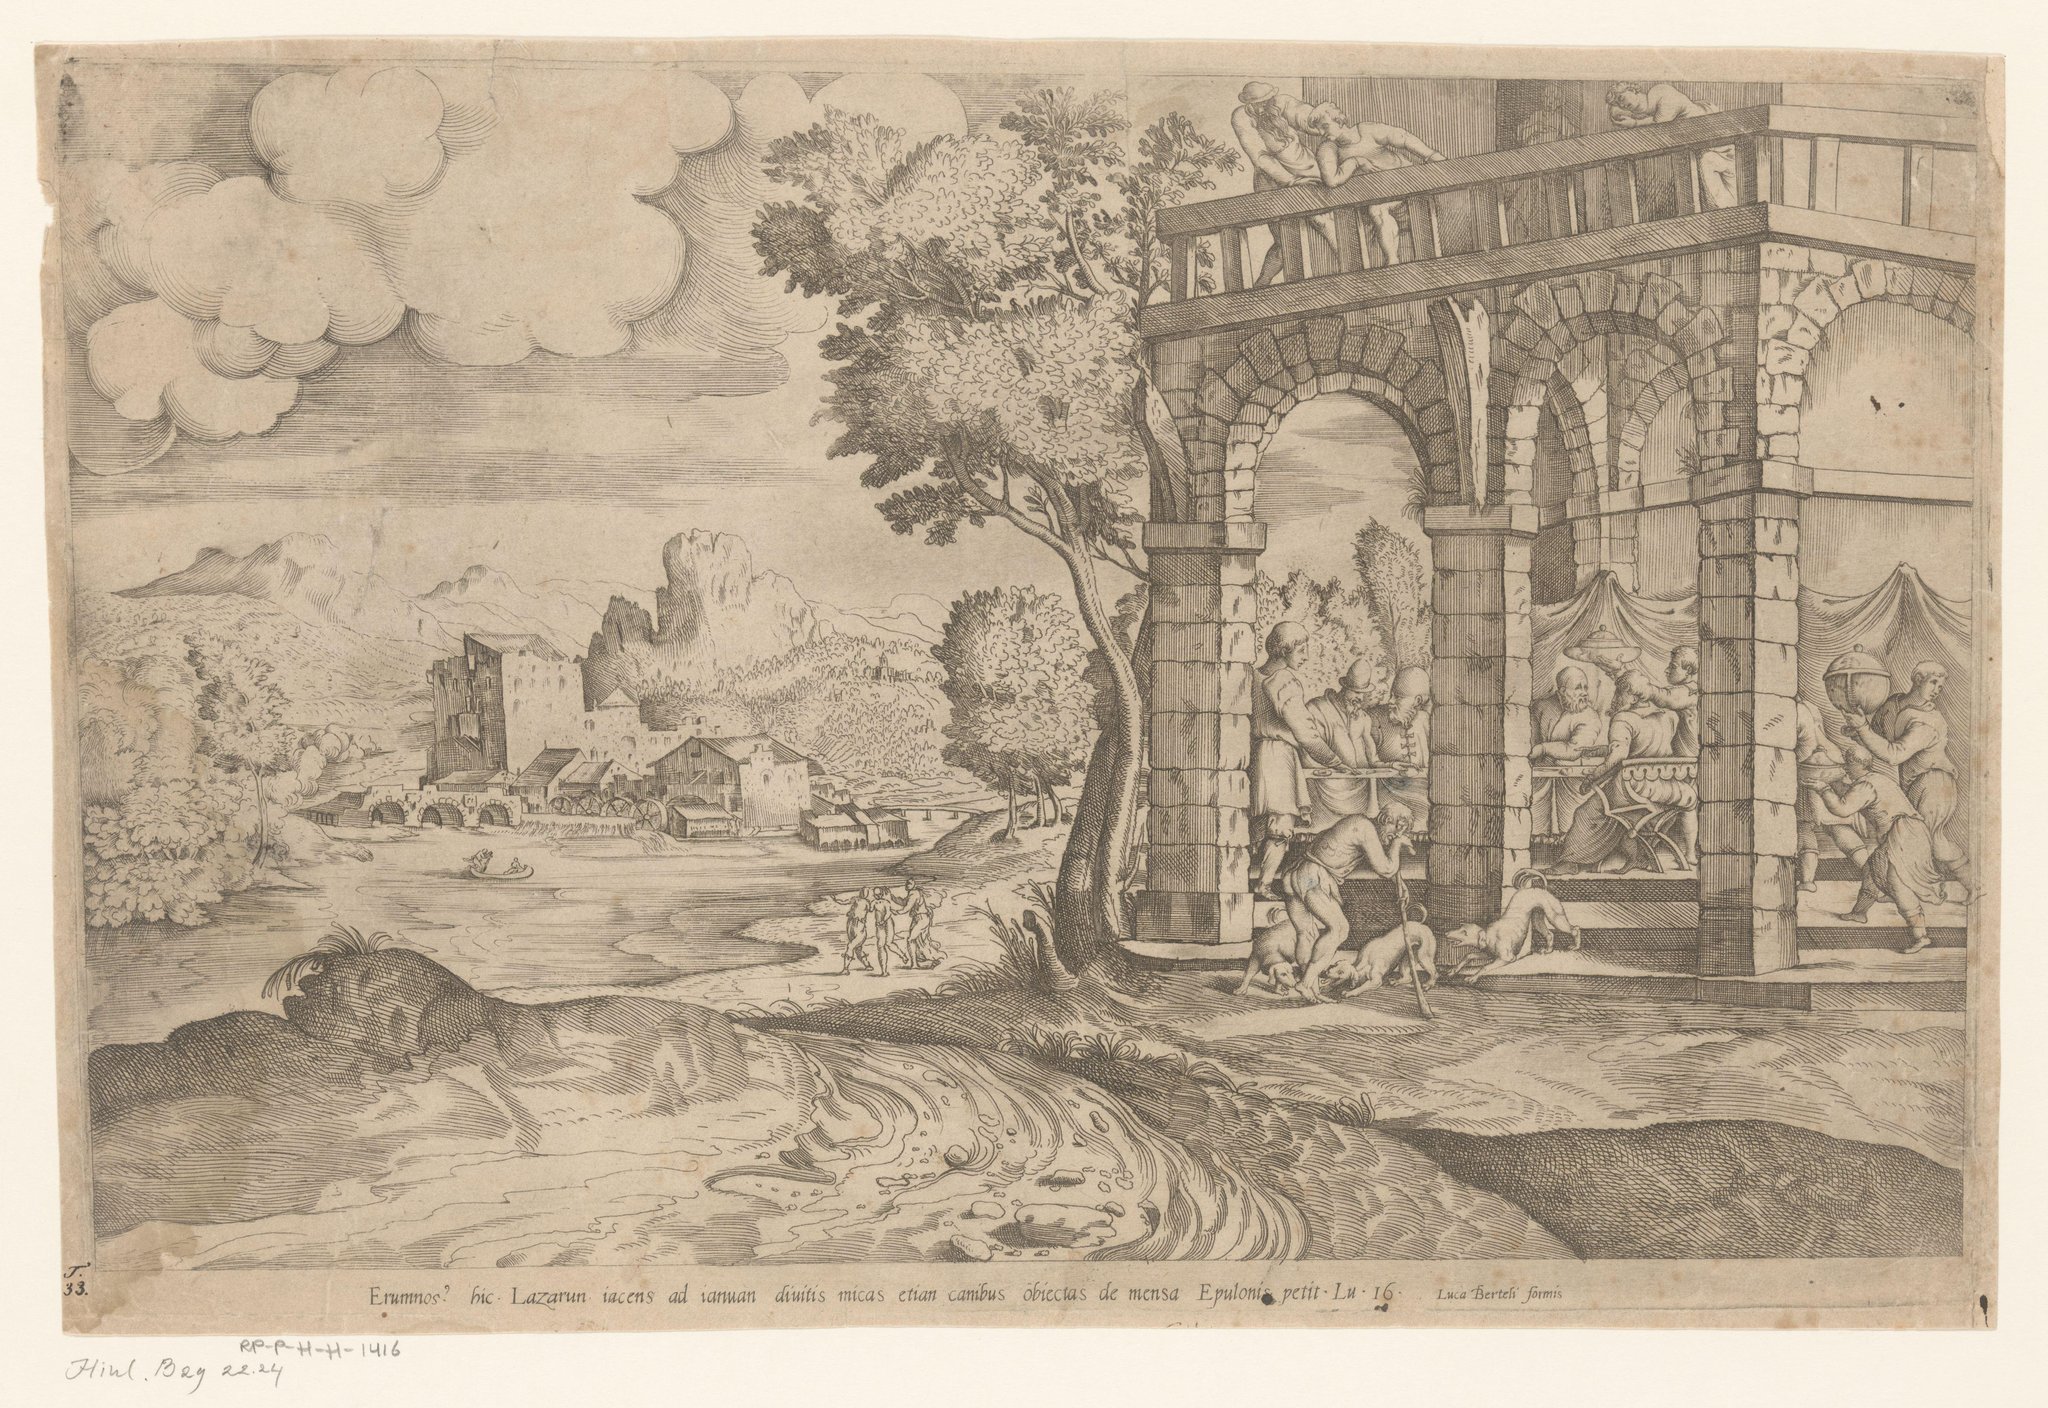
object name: print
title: Rijke man en de arme Lazarus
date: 1564-1589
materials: paper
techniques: engraving, etching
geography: italy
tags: landscapes, landscape with ruins, the rich man (dives) is feasting, while poor lazarus is starving at the gate (dogs licking lazarus' sores) (luke 16:19-31)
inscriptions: number: ‘T. 33.’, collector's mark: Lugt 2228, collector's mark: Lugt 11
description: Landschap met een dorp aan een rivier. Op de voorgrond rechts een ruïne van een paleis. In de ruïne dineren de rijke man en zijn gasten. Voor de ruïne staat de arme Lazarus tussen drie honden.